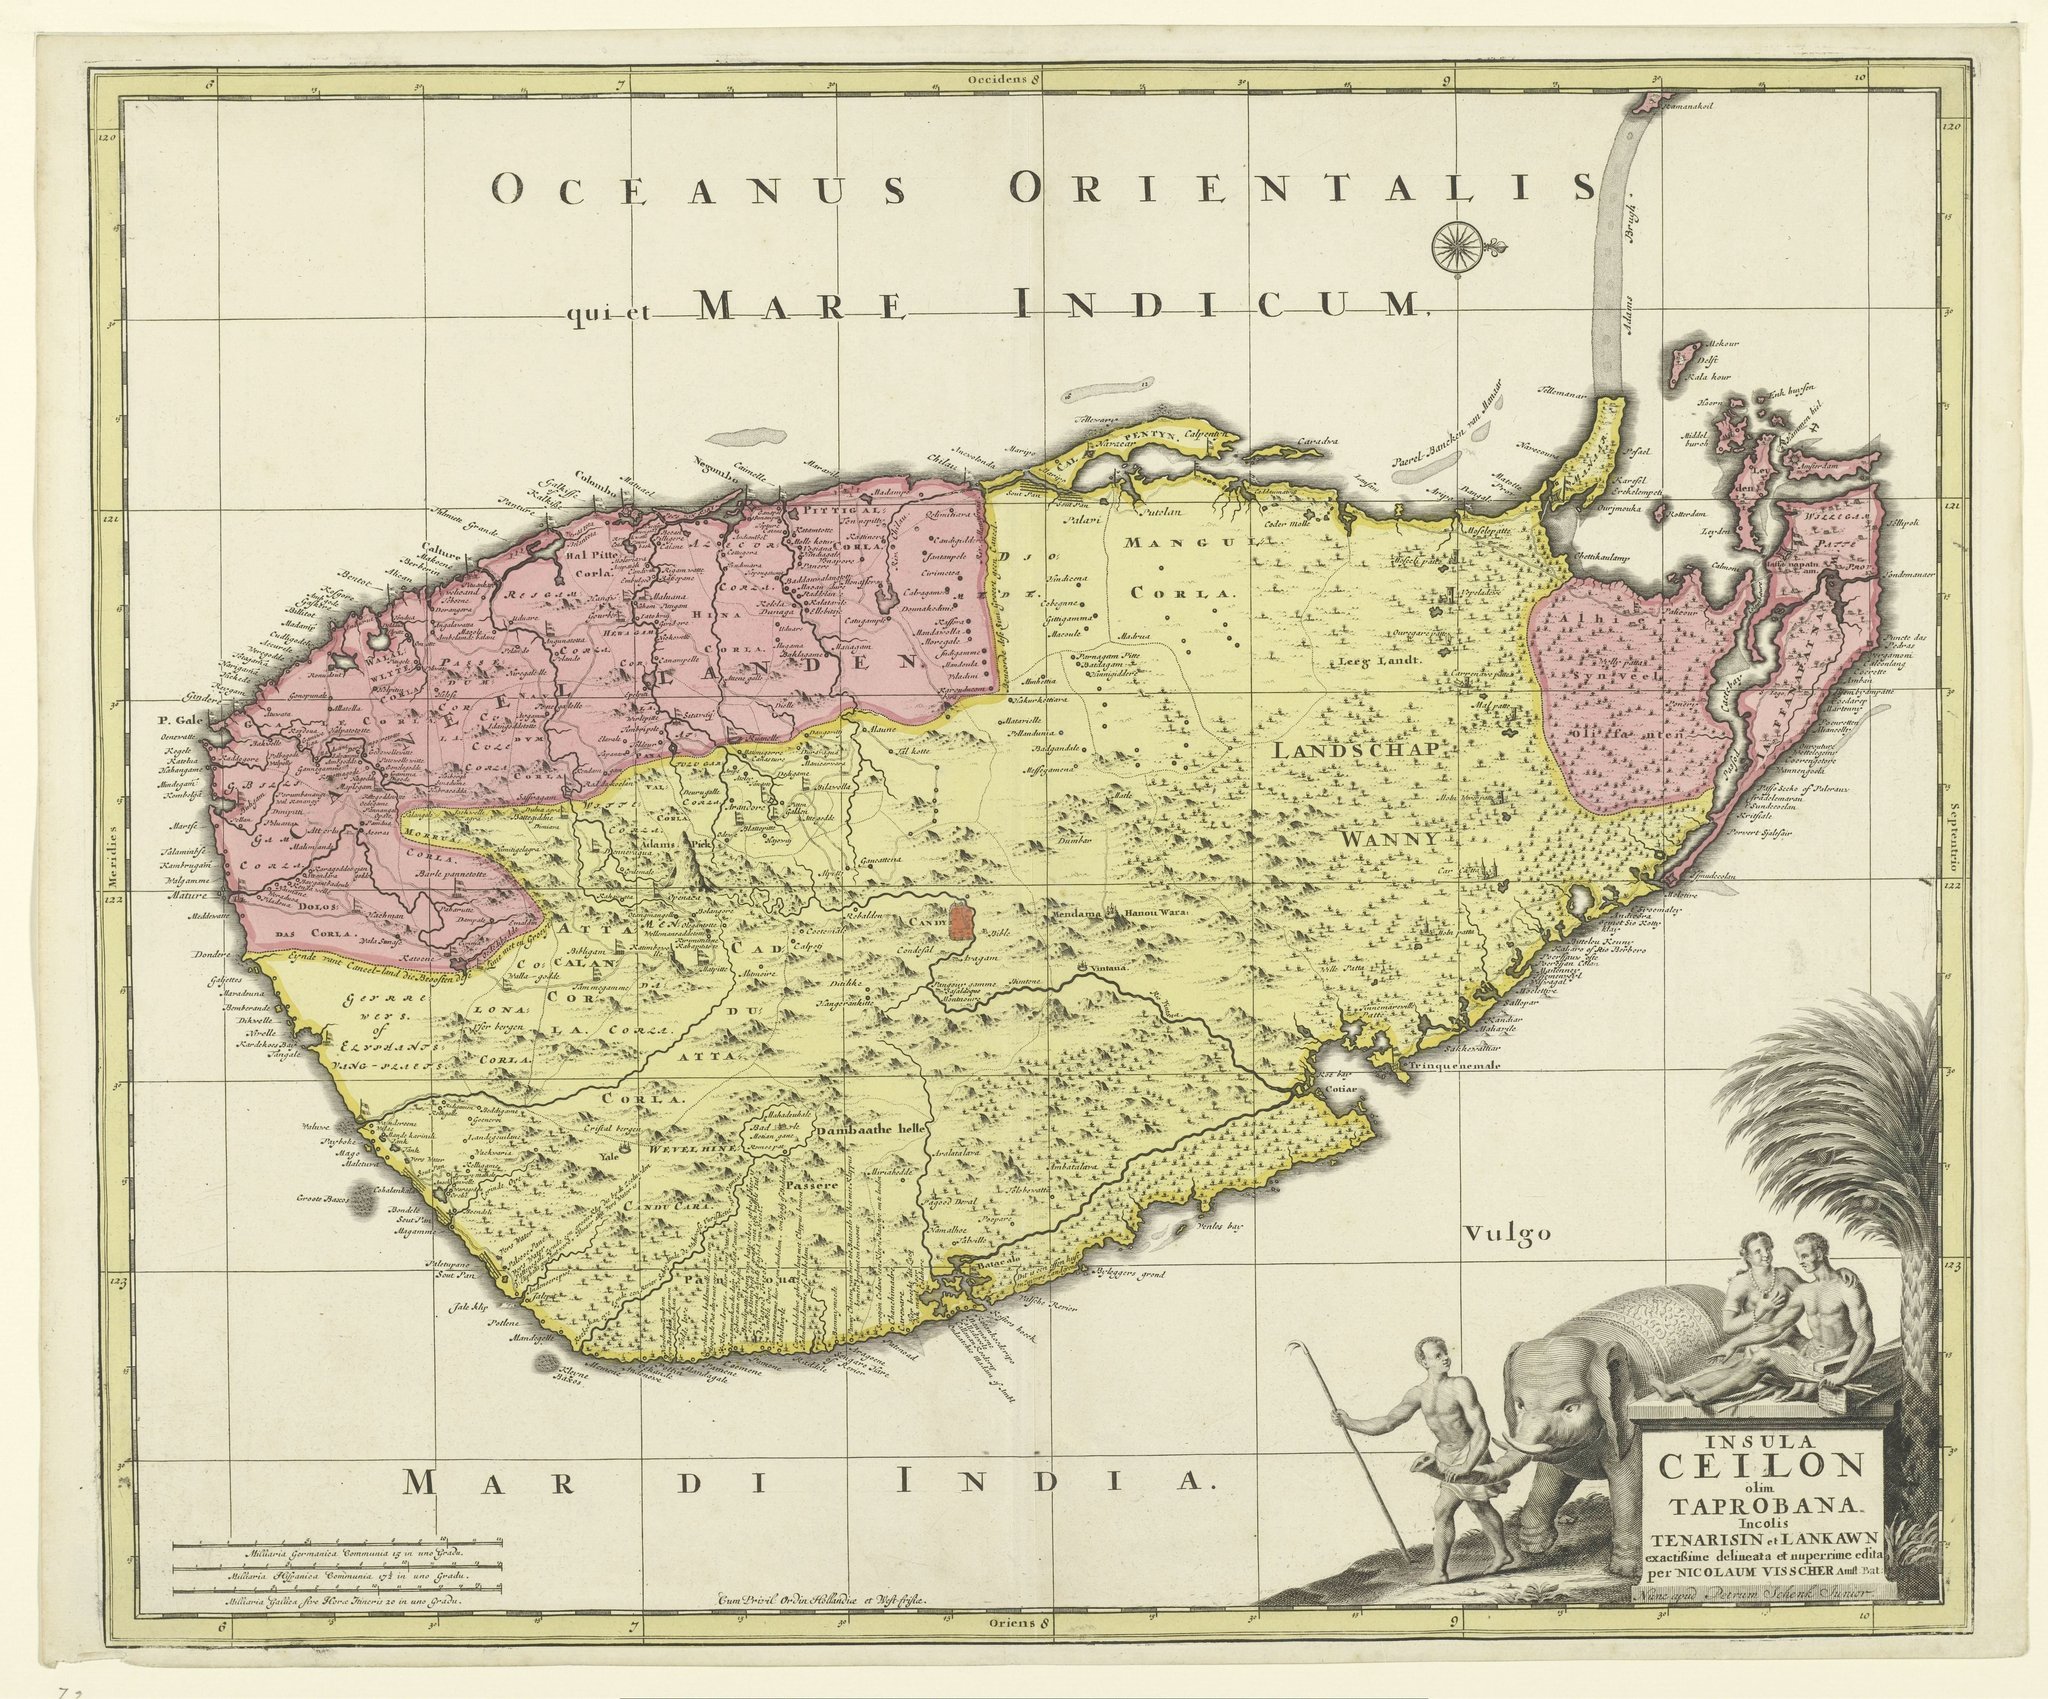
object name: print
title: Kaart van Ceylon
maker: nicolaes visscher (ii)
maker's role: publisher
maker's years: 1649-1702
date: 1650-1700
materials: paper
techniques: engraving, hand coloring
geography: amsterdam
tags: maps of separate countries or regions, sri lanka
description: Kaart van Ceylon, met het noorden rechts, de verschillende gebieden in verschillende kleuren. rechtsonder rond het opschrift: twee Sri Lankaanse mannen en een vrouw, een olifant en een palmboom. Linksonder schaal in Duitse, Spaanse en Franse mijlen. Windroos rechtsboven (1:300.000). Verso: een kaartje met 'CEYLON' geplakt.